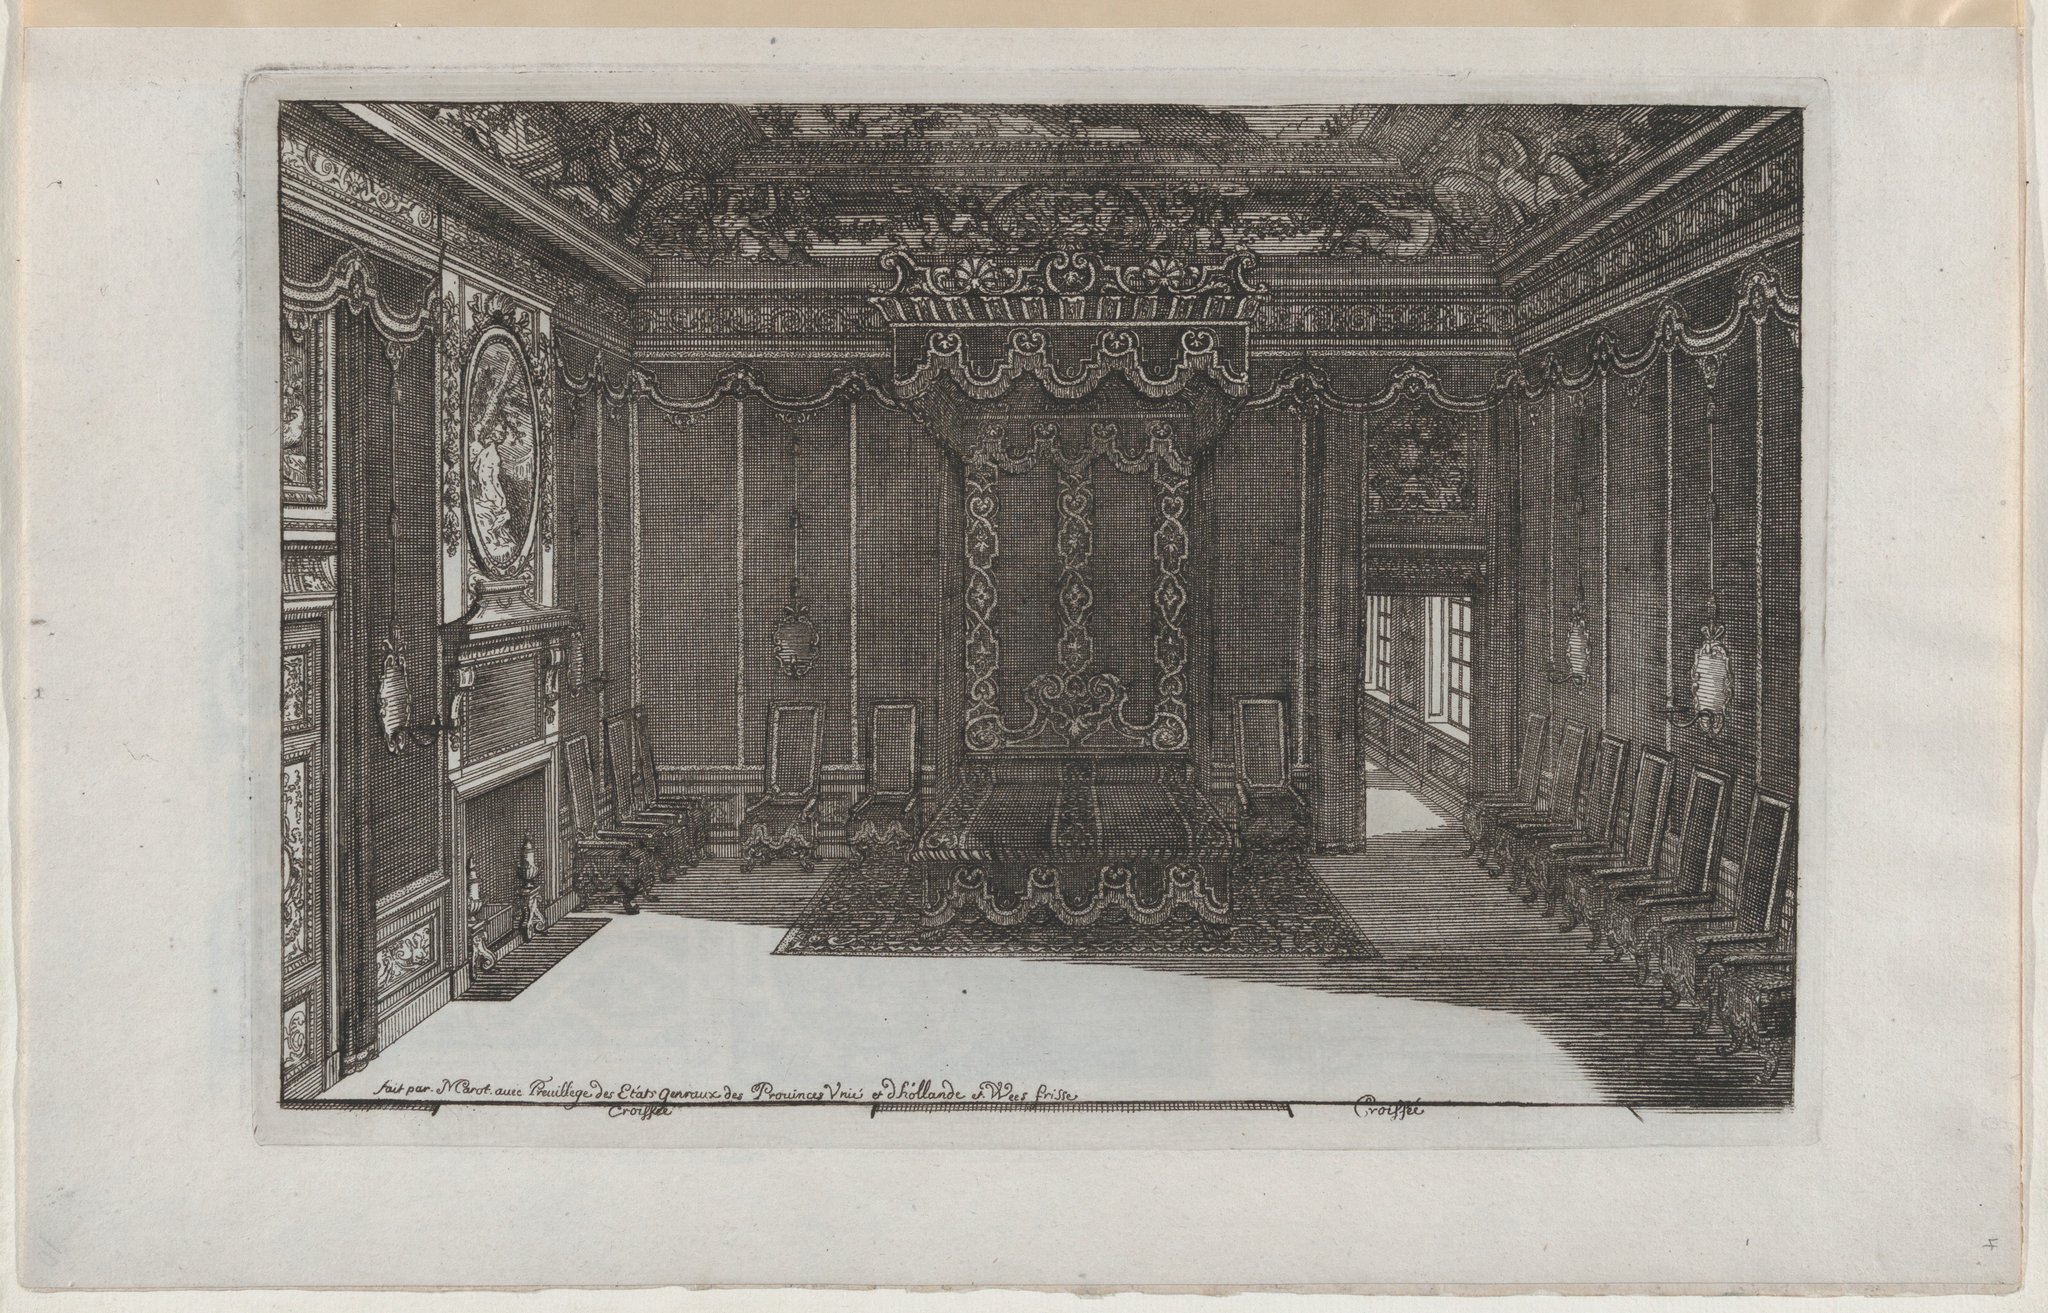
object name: print collection ornament architecture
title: Interior with a Canopy Bed and a Row of Chairs Lining the Walls, from Nouveaux Liure da Partements, part of Œuvres du Sr. D. Marot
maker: daniel marot the elder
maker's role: artist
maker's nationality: french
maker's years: 1661-1752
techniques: etching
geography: netherlands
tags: fireplaces,interiors,bedrooms,beds,chairs